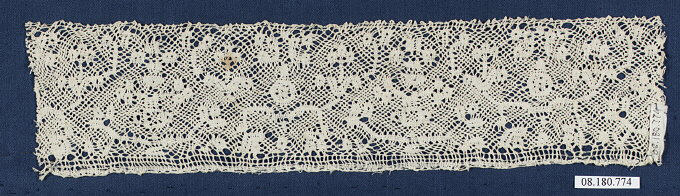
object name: fragment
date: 1701-1800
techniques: lace